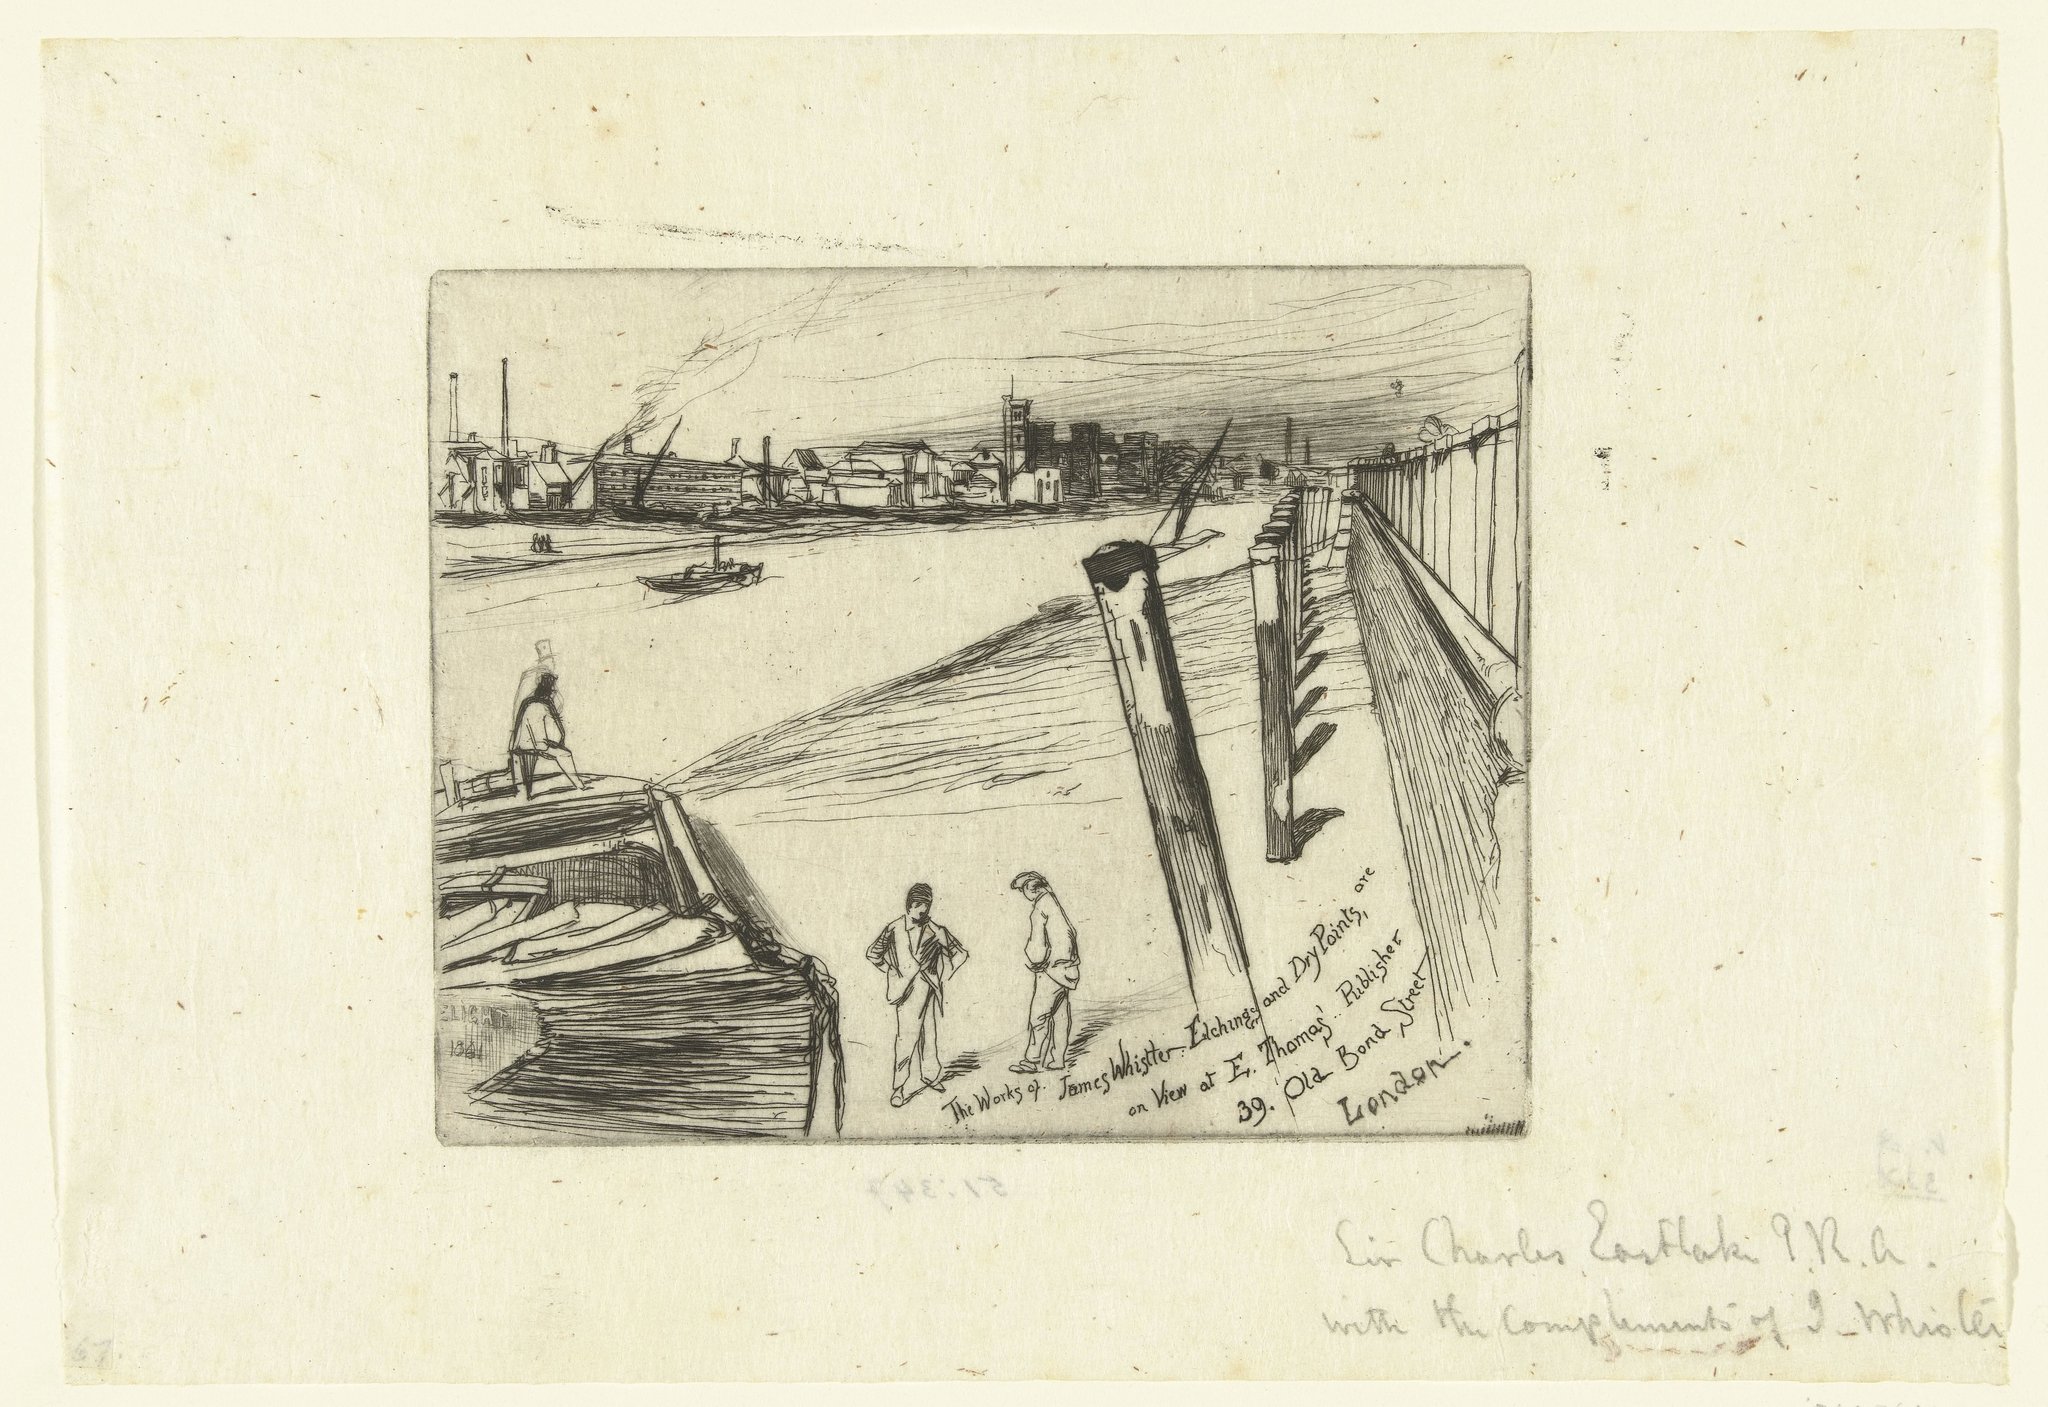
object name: invitation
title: Millbank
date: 1861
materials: paper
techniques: drypoint, etching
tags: river bank, thames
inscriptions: inscription: ‘Sir Charles Eastlake P.R.A. with the compliments of J. Whistler’, inscription: ‘The Works of James Whistler: Etchings and DryPoints, are on View at E. Thomas' Publisher 39, Old Bond Street London.’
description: Gezicht op de rivier de Theems bij Millbank, Londen. Drie mannen staan bij een schip op de oever. Rechtsonder een vierregelig opschrift in het Engels.